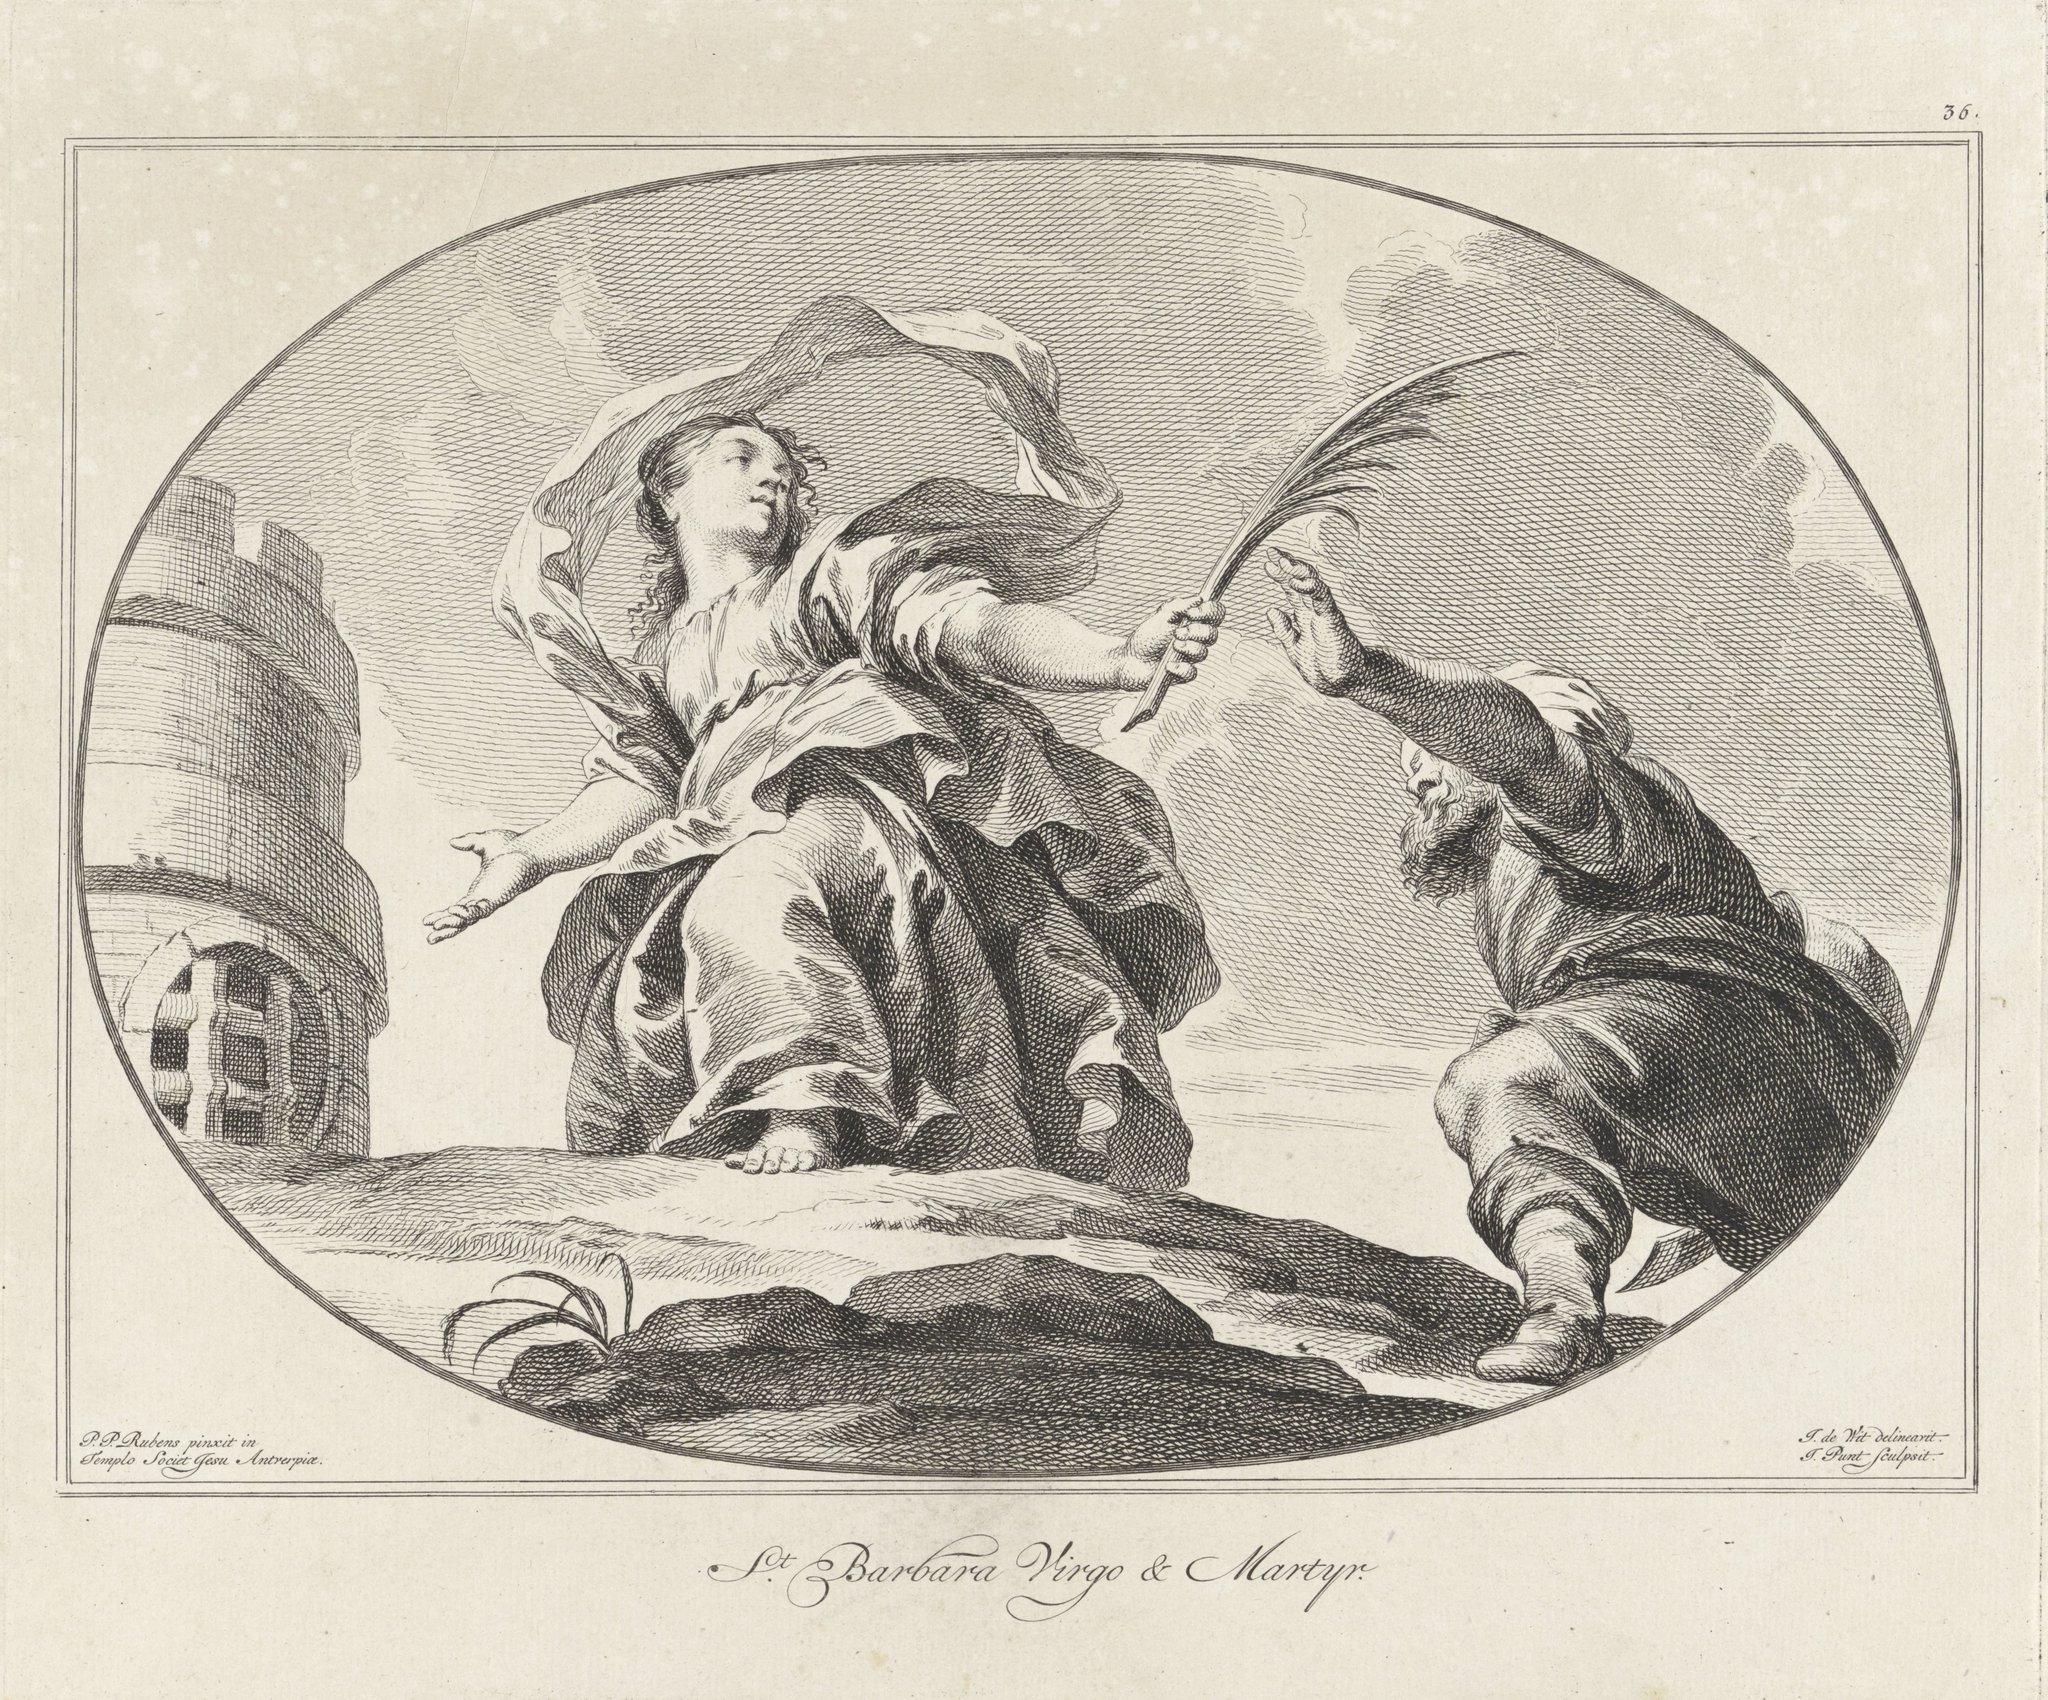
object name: print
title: H. Barbara van Nicomedië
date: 1751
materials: paper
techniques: engraving, etching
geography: amsterdam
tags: the virgin martyr barbara; possible attributes: book, cannon(ball), crown, cross, chalice with wafer, dioscuros (her father), peacock feather, sword, torches, mason's tools, tower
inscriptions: collector's mark: Lugt 240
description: De heilige Barbara van Nicomedië, met palmtak in de hand, wijst naar de toren achter haar. Haar vader loopt op haar af. Onder de ovale voorstelling een opschrift in het Latijn.